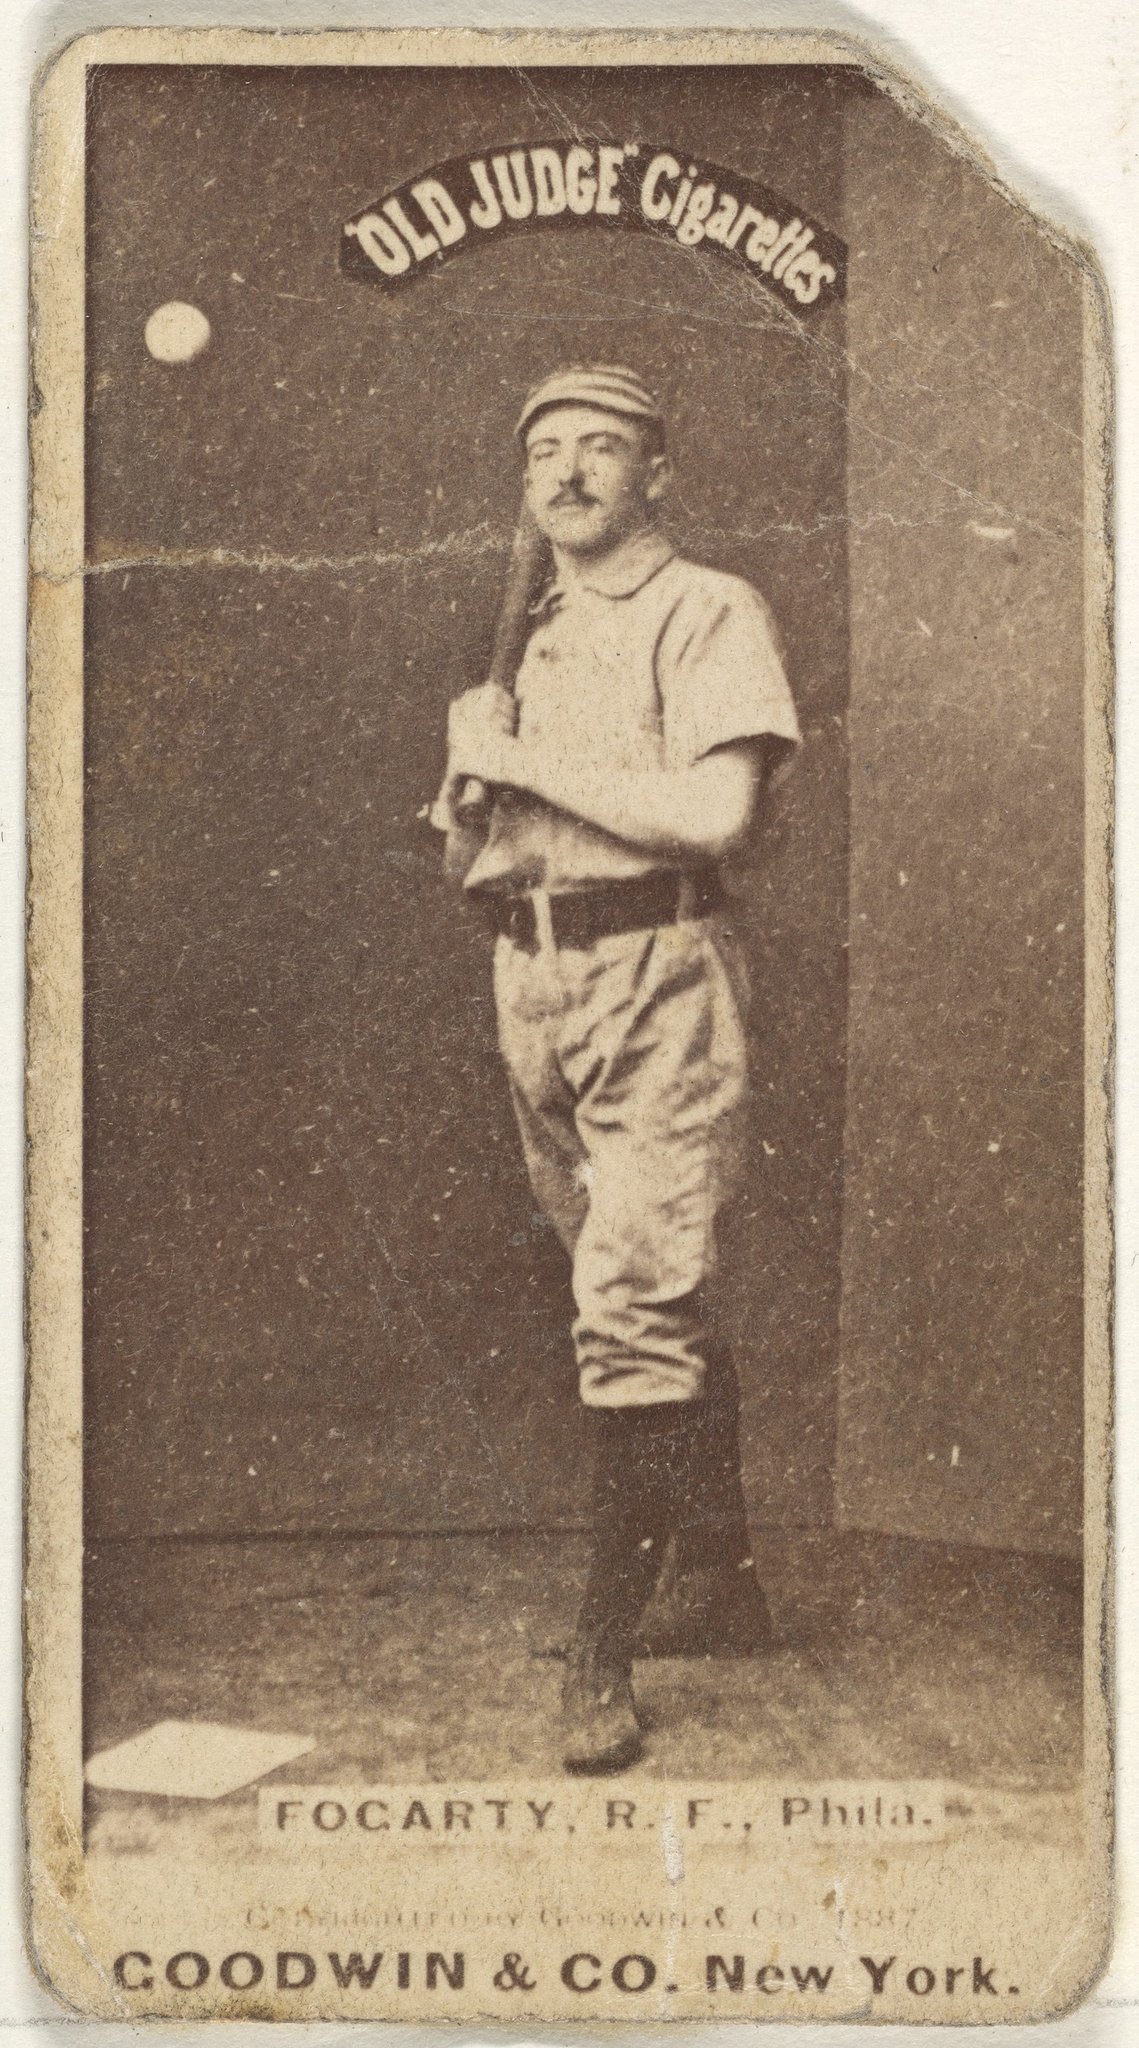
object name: baseball card, photograph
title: James G. Fogarty, Right Field, Philadelphia, from the Old Judge series (N172) for Old Judge Cigarettes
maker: goodwin & company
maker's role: publisher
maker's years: 1850-1950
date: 1887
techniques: albumen silver print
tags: men,portraits,baseball,athletes